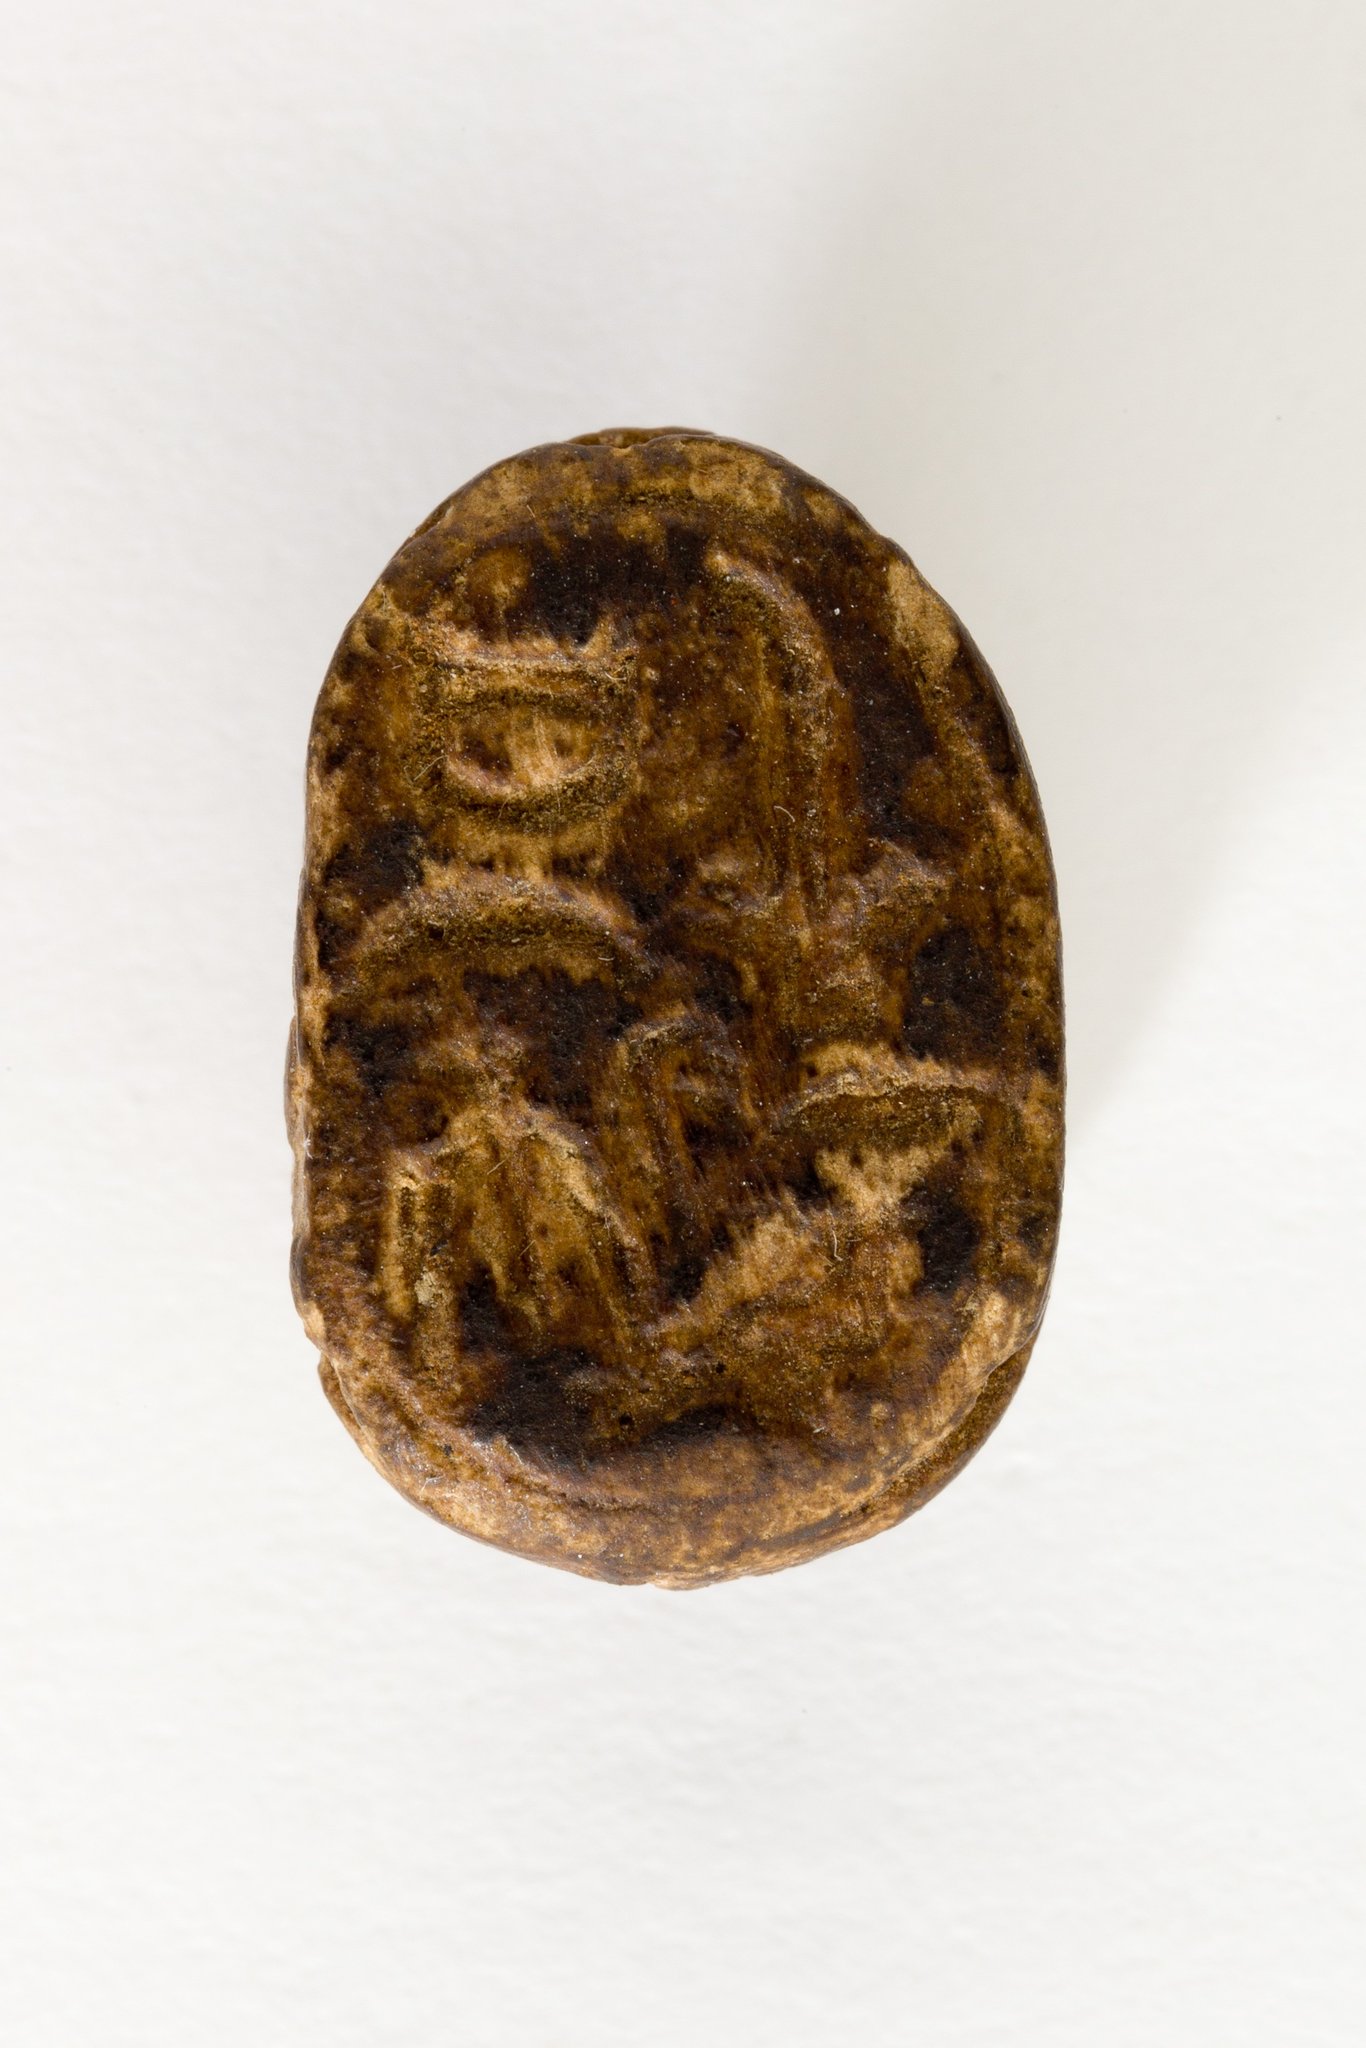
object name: scarab, ahmose nefertari, king's wife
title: Scarab Inscribed for the Principal Queen Ahmose(-Nefertari)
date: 1550-1525 BCE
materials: stone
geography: egypt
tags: hieroglyphs,scarabs